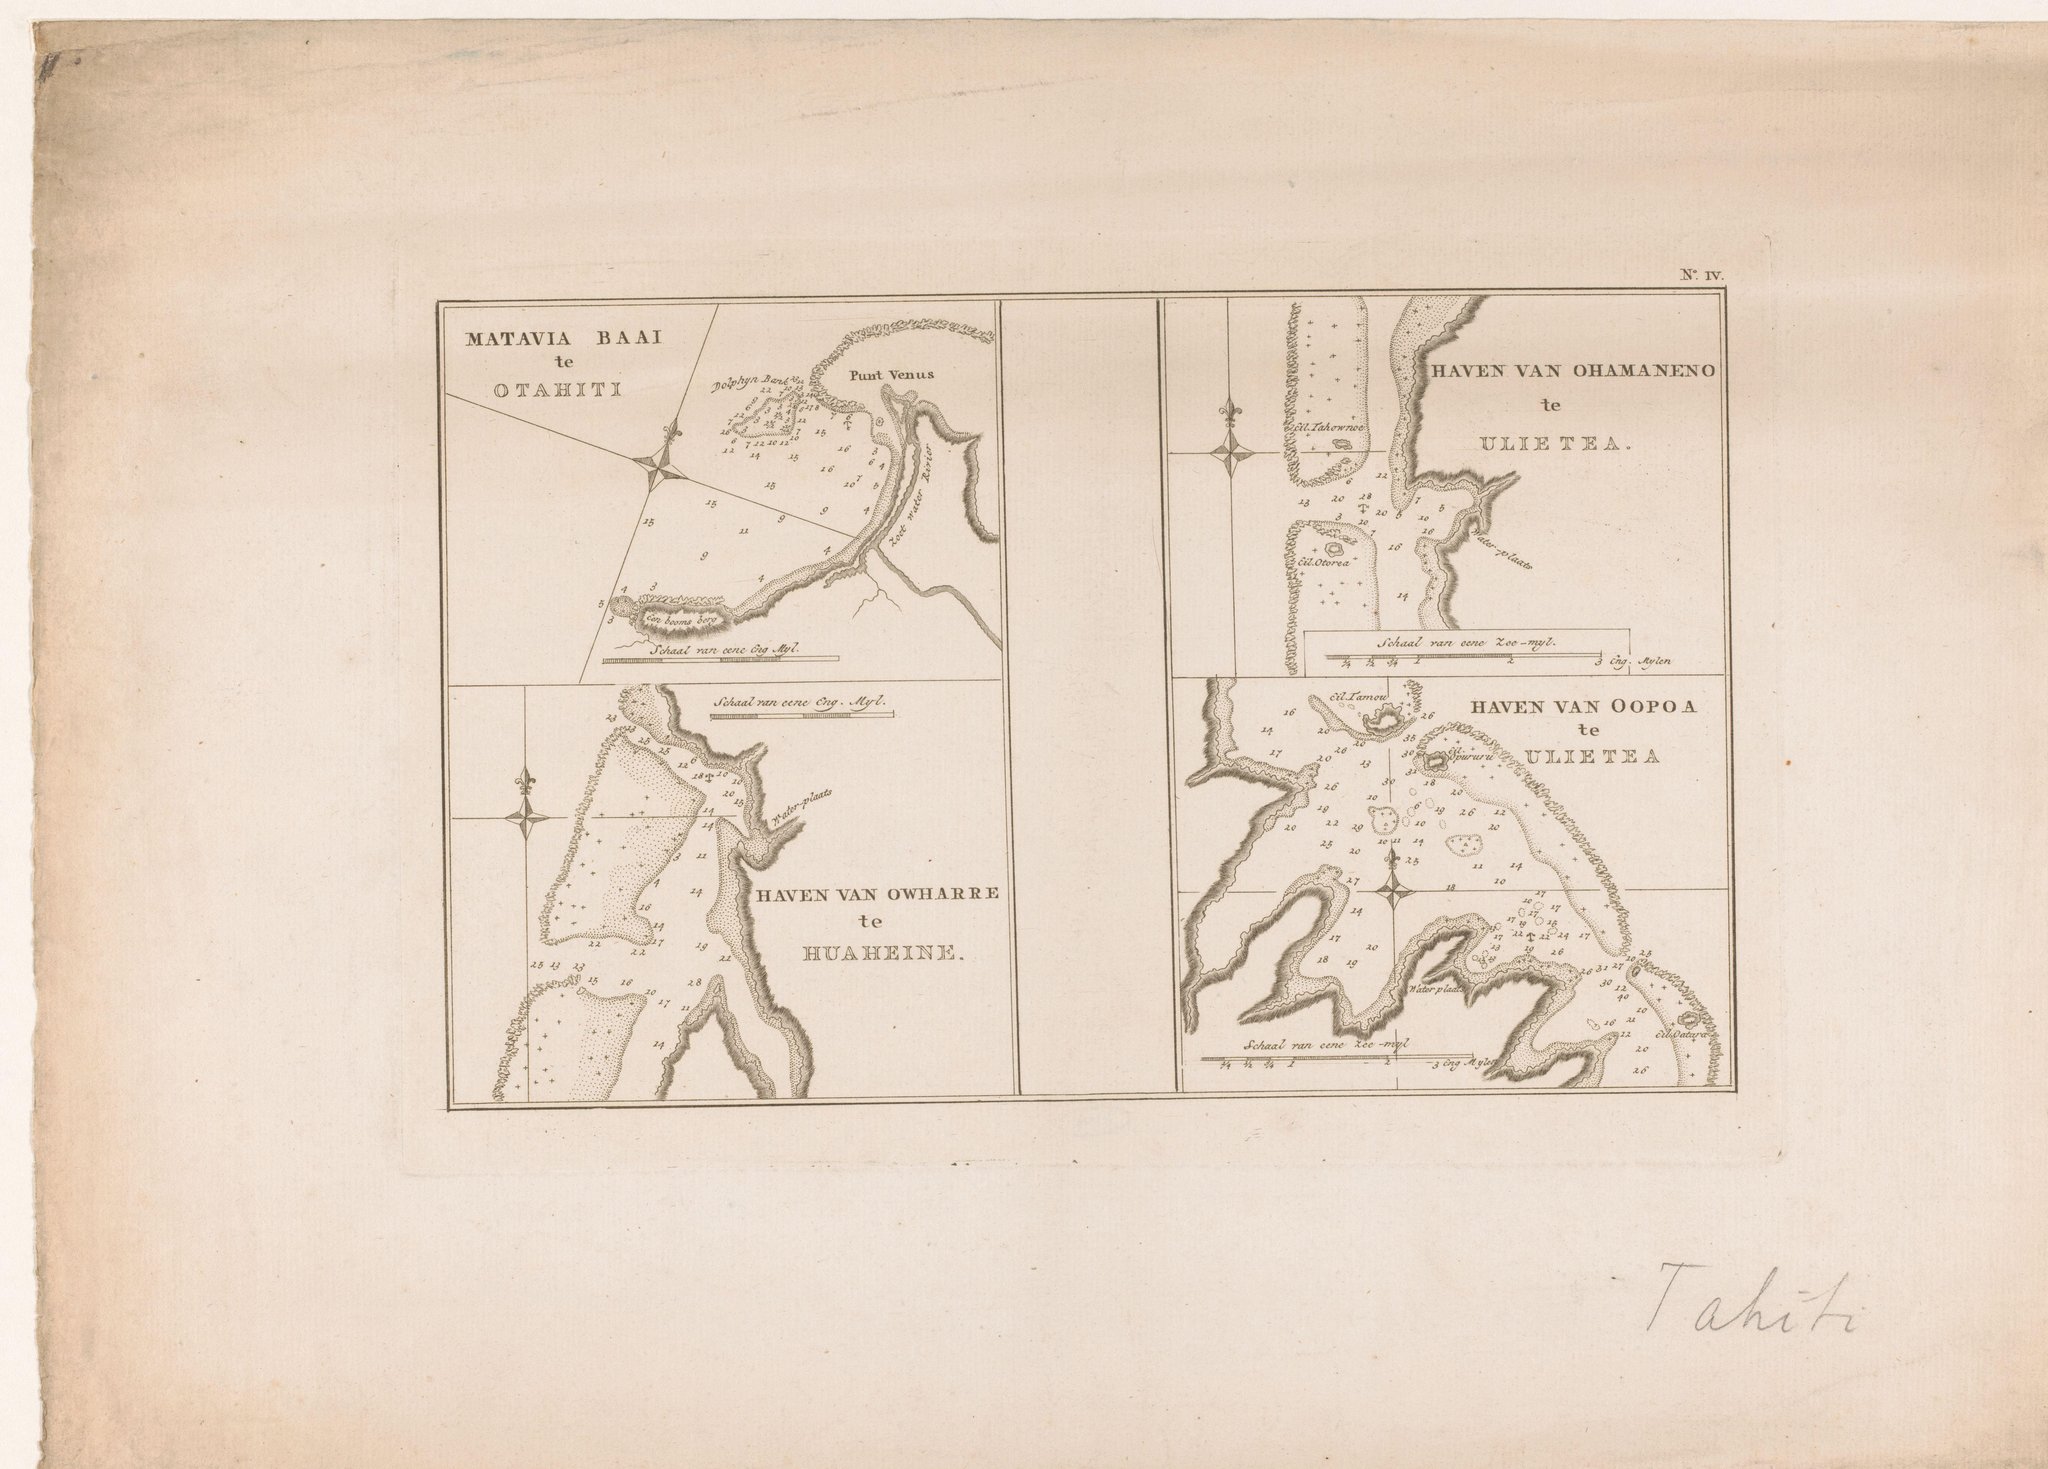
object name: map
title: Kaart van de kusten van de eilanden Tahiti, Raiatea en Huahine in Frans-Polynesië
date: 1797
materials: paper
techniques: etching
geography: leiden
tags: island, maps, atlases, french polynesia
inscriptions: collector's mark: Lugt 2228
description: Prent uit: Cook, James. Reize rondom de Waereld (...) met kaarten en plaaten. [Vertaald uit het Engels door] Jan David Pasteur. Leiden: Honkoop, Amsterdam: Allart, Den Haag: Van Cleef, 1797, dl. 2, p. 1.